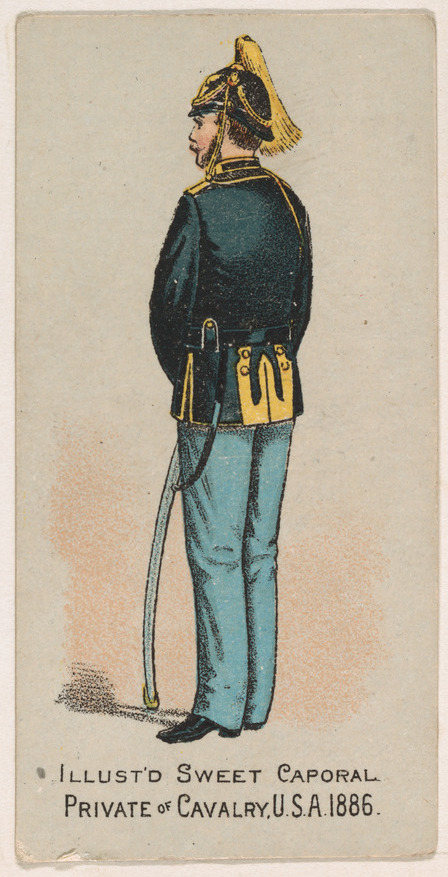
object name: print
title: Private of Cavalry, United States Army, 1886, from the Military Series (N224) issued by Kinney Tobacco Company to promote Sweet Caporal Cigarettes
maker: kinney brothers tobacco company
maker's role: publisher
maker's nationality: american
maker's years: 1869-2011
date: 1888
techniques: color lithograph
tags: soldiers,swords,men,profiles